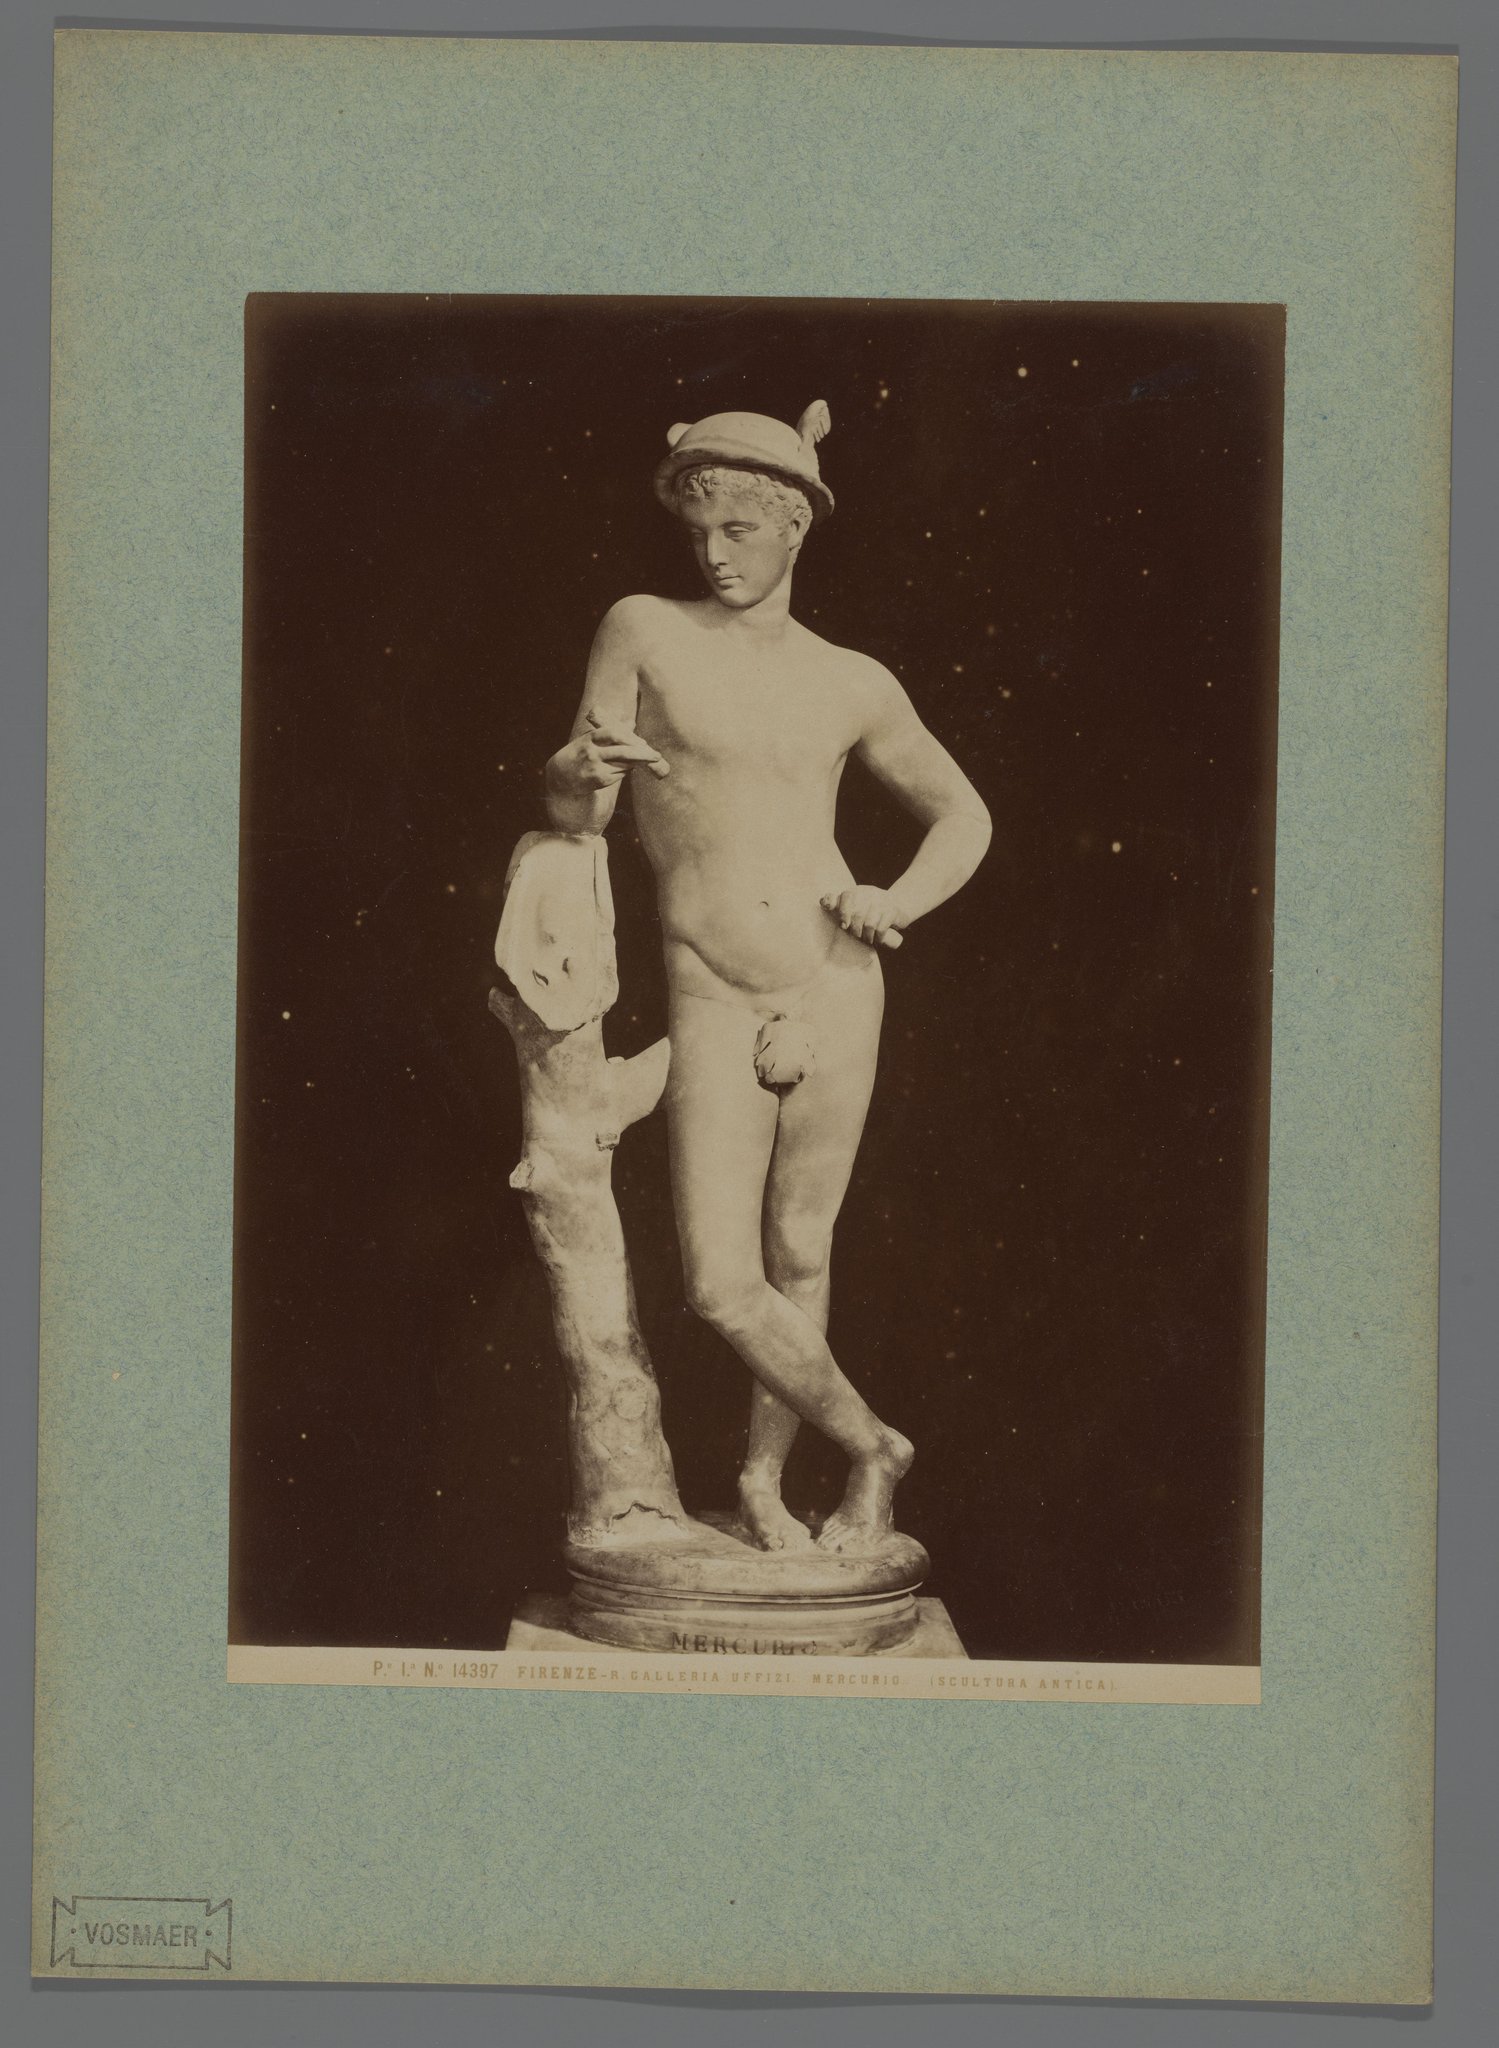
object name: photograph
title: Sculptuur van Mercurius in de Galleria degli Uffizi te Florence, Italië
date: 1857-1900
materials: cardboard, paper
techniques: albumen print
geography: florence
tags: (story of) mercury (hermes), piece of sculpture, reproduction of a piece of sculpture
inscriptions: number: ‘Pt.1a.No. 14397’, collector's mark: ‘VOSMAER’